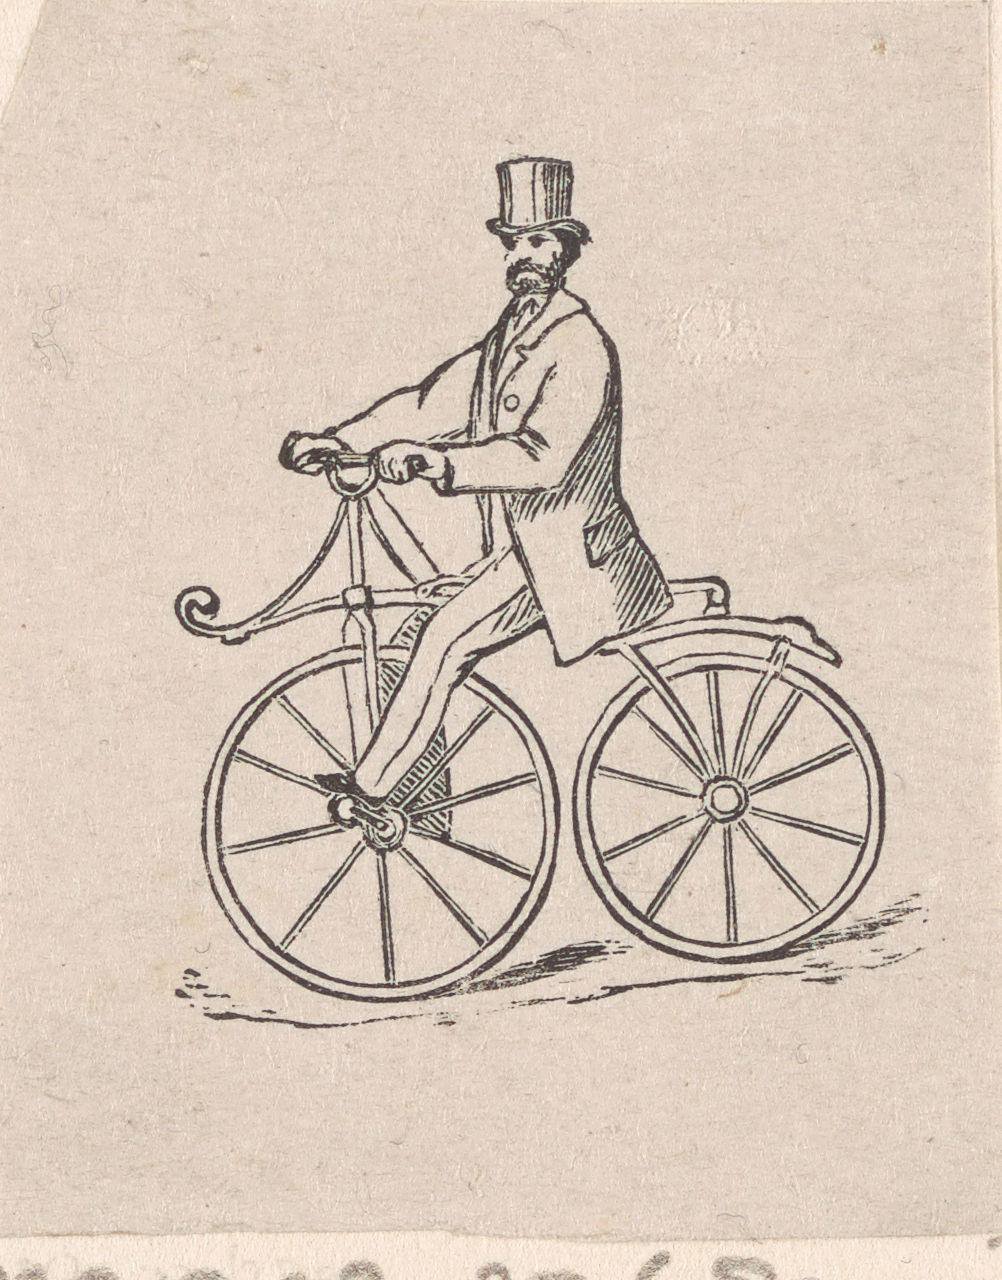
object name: print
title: Man met een hoge hoed op een fiets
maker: isaac weissenbruch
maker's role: print maker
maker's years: 1826-1912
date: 1869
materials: paper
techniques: engraving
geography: netherlands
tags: antique types of bicycles, adult man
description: De afbeelding werd gebruikt door de Nederlandsche Metaalwaren Fabriek van Johannes Theodorus Scholte (1827-1891) te Amsterdam.